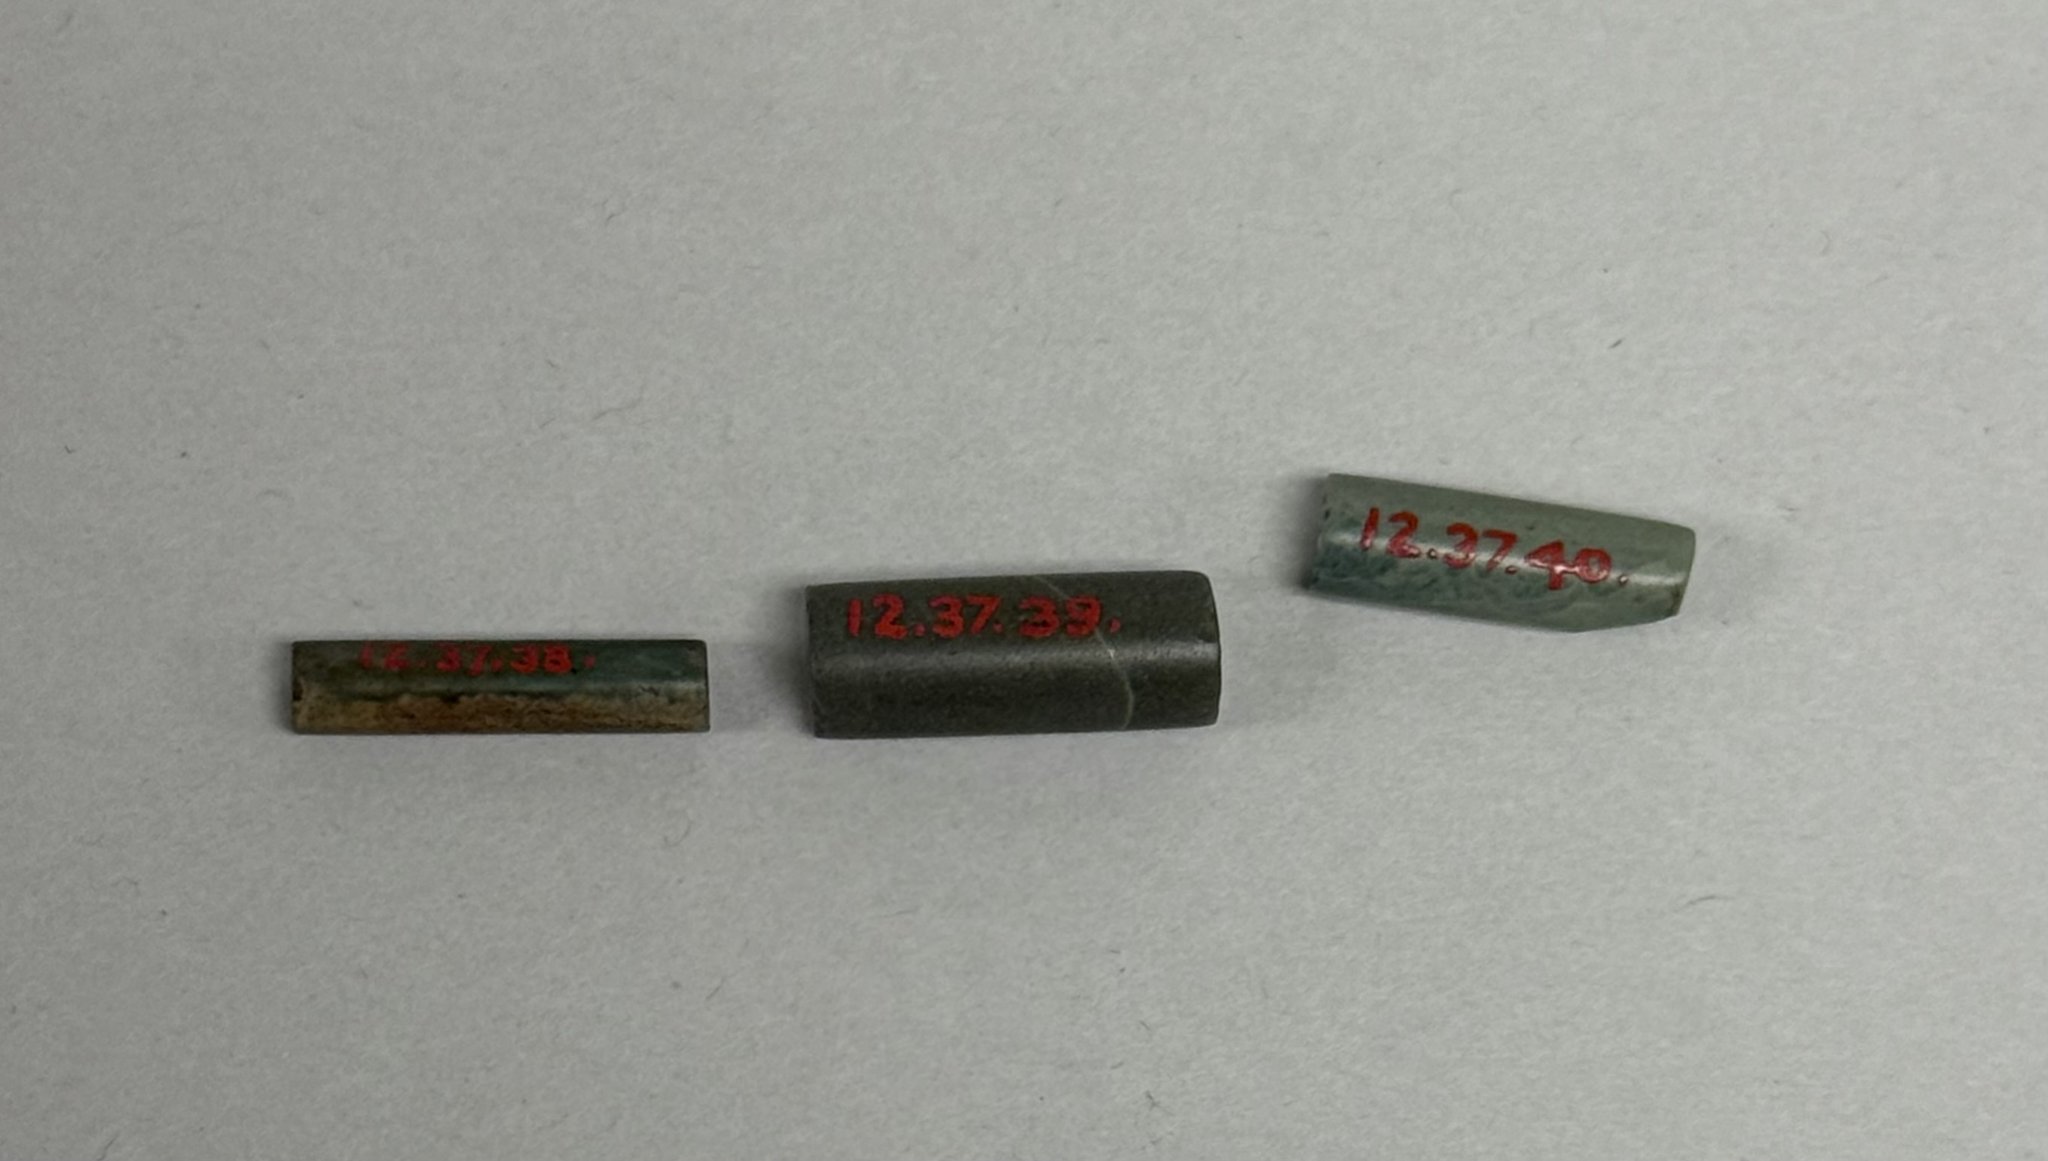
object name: cylinder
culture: japanese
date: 601-700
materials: jasper